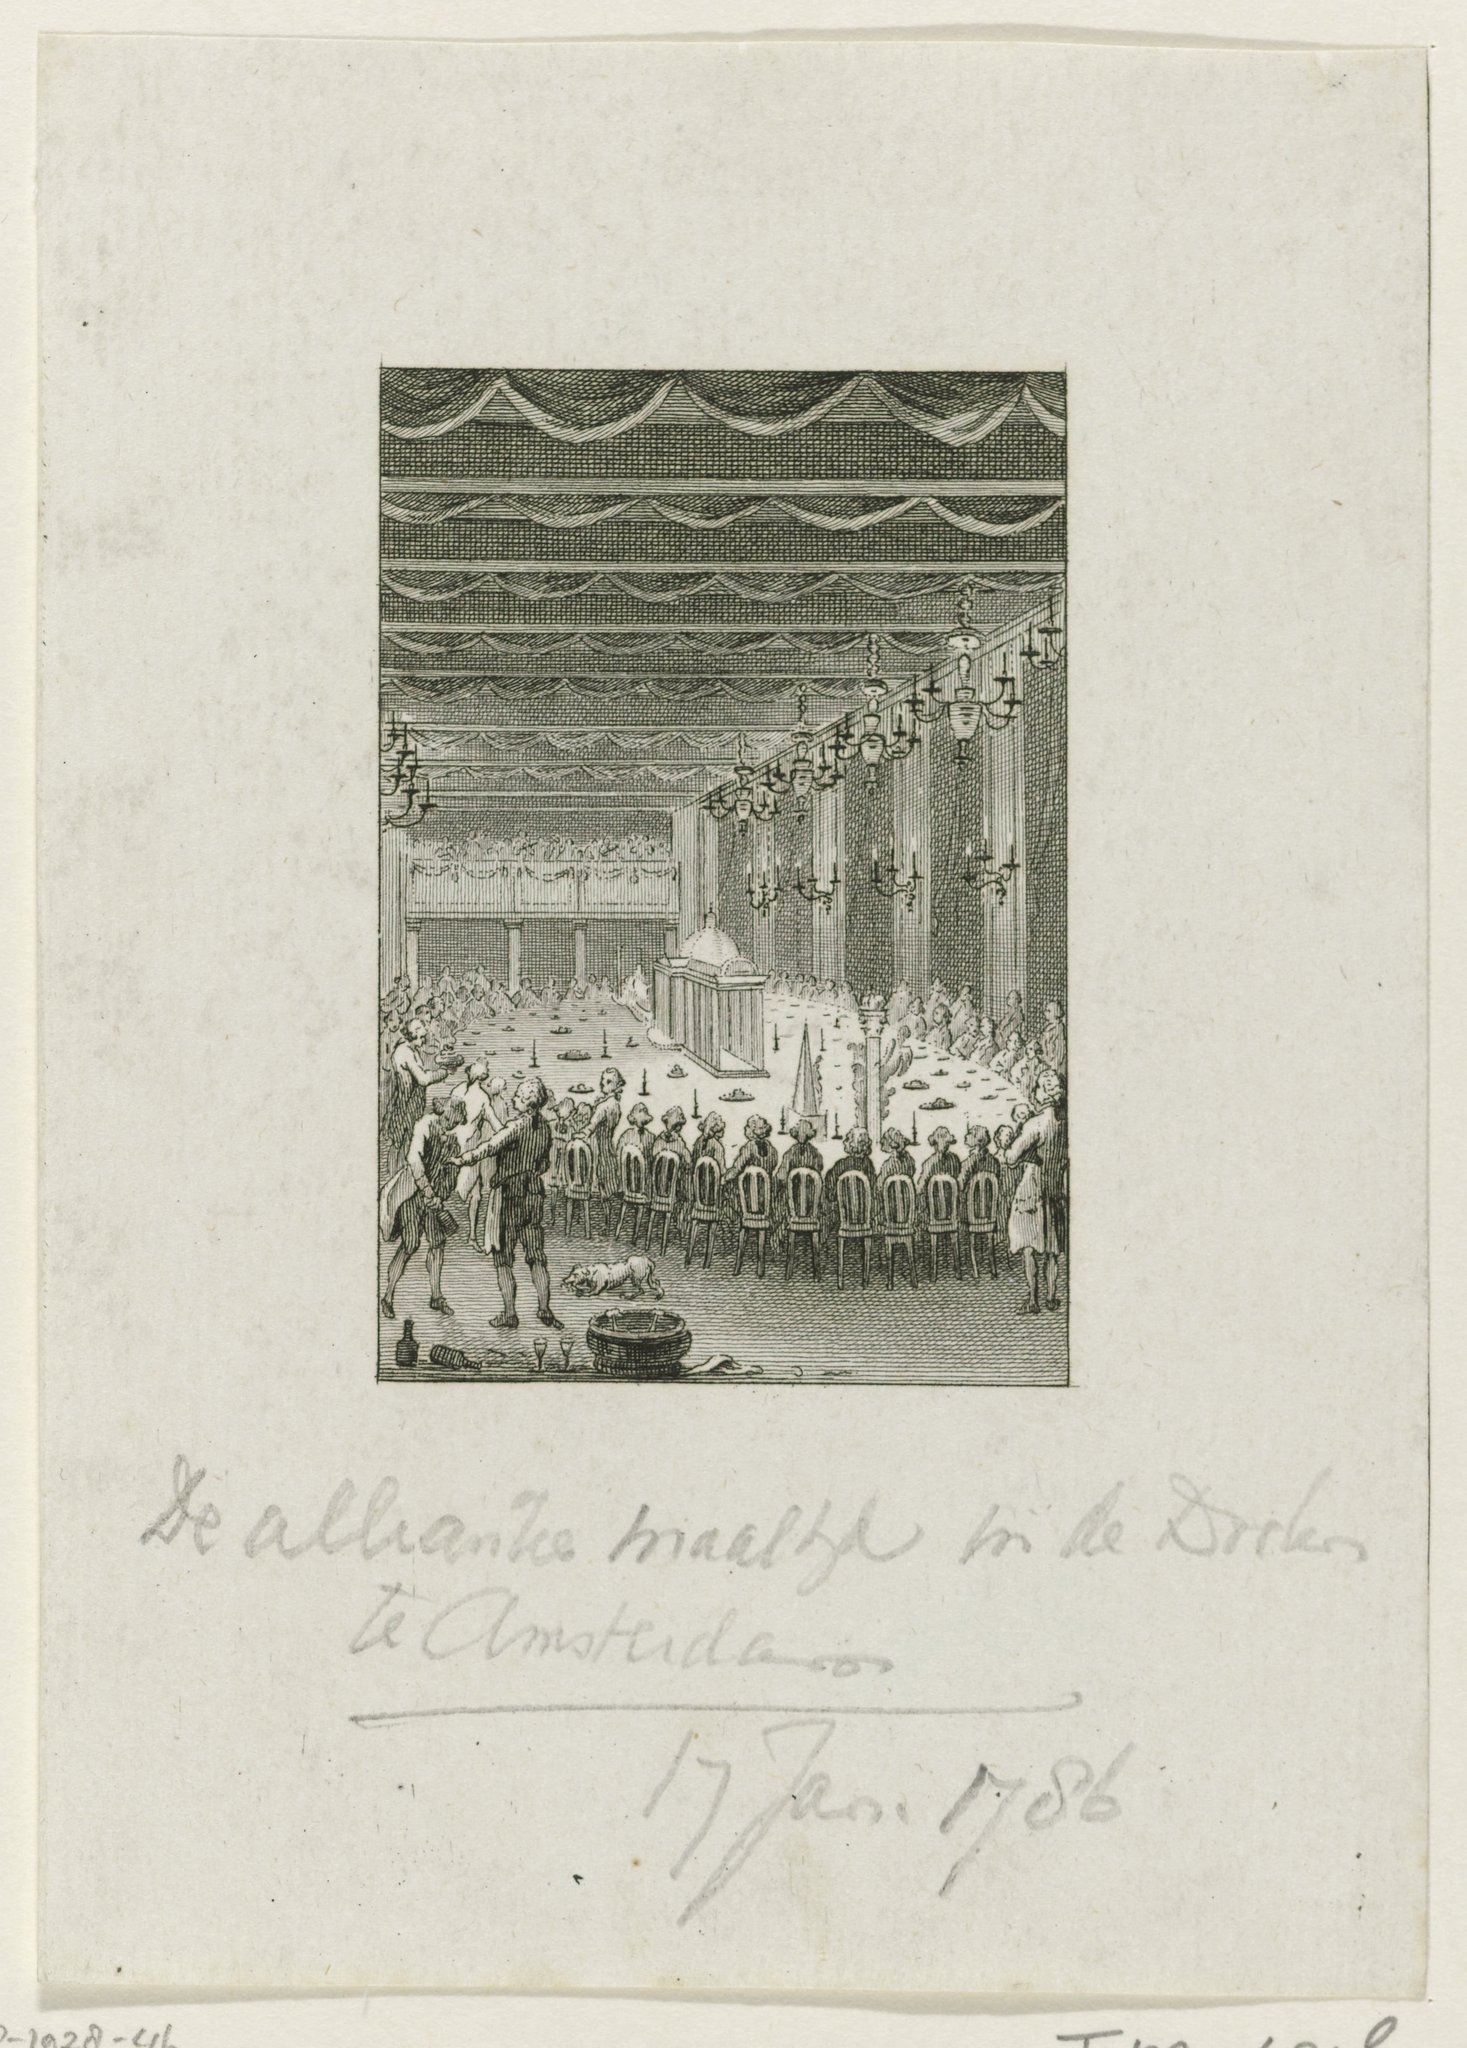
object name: print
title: Alliantiemaaltijd te Amsterdam, 1786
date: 1786-1795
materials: paper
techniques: engraving, etching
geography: northern netherlands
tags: festivities on events of national importance (+ eating and drinking ~ festive activities), celebration meal, feast, banquet, alliance with france (1785)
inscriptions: collector's mark: Lugt 2228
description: De feestelijke maaltijd gehouden op 27 januari 1786 in de Garnalen Doelen (Handboogdoelen) te Amsterdam om de Alliantie met Frankrijk (gesloten op 10 november 1785) te vieren. Groot gezelschap gezeten aan een tafel versierd met tafelstukken.